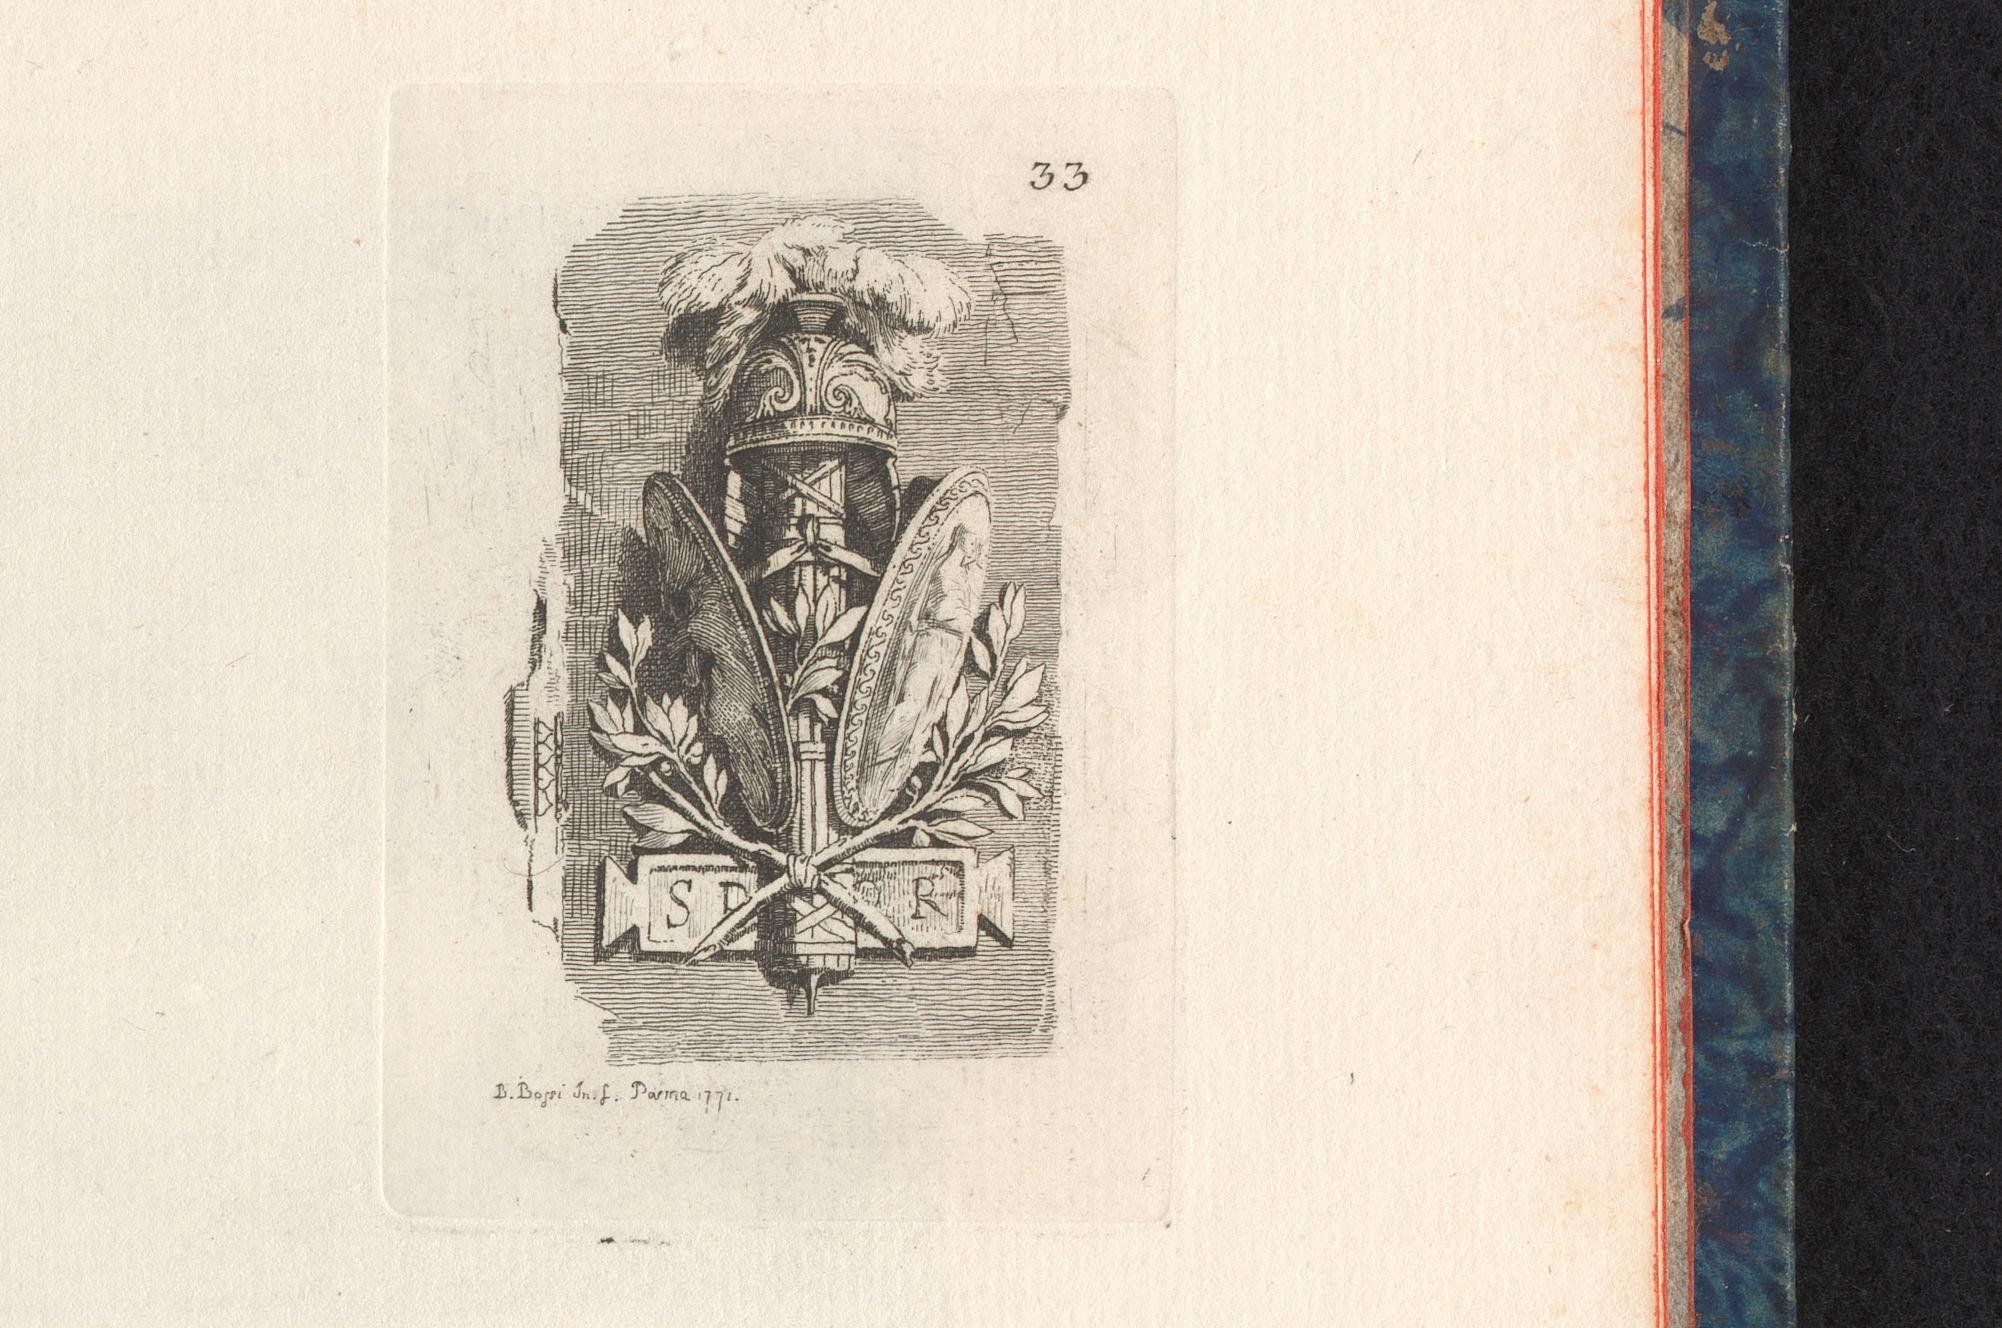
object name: album leaf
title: Raccolta di teste, pensieri, trofei e prove varie d'acquaforte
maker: benigno bossi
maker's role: print maker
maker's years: 1727-1792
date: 1771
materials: paper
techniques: etching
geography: parma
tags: trophy, i.e.: decorative arrangement of symbolic or typical objects ~ ornament